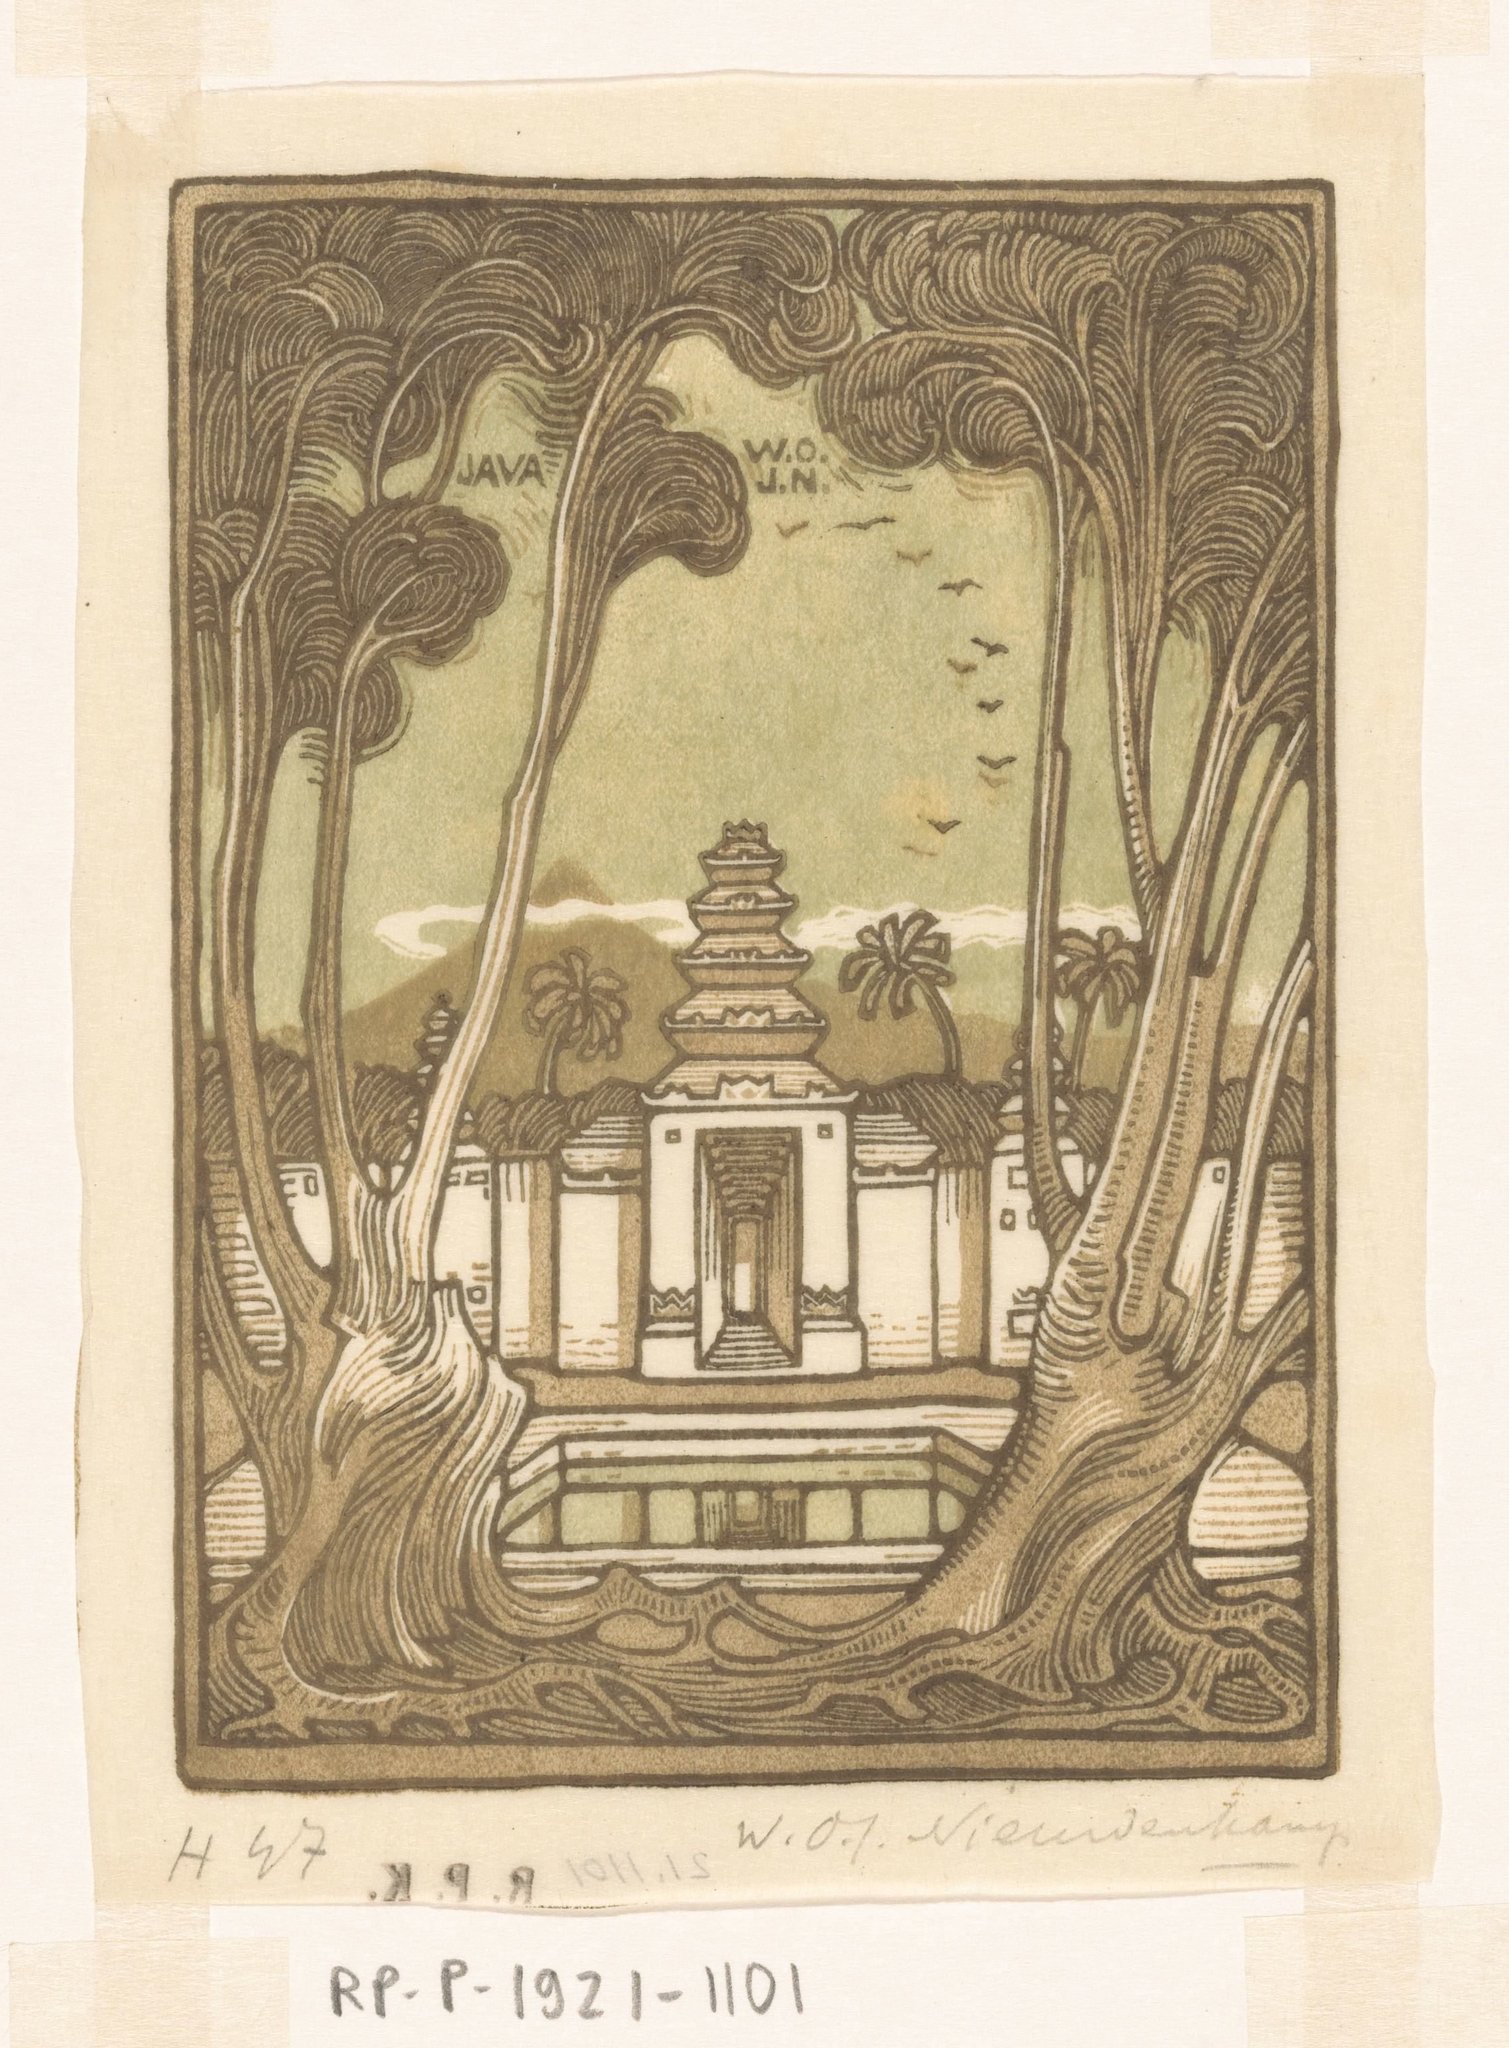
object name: print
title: Heile begraafplaats, Java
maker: wijnand otto jan nieuwenkamp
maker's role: draughtsman, print maker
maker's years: 1874-1950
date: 1903-1911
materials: paper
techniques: woodcut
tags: trees, gate, entrance, pond, pool, cemetery, park-like burying ground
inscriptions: collector's mark: Lugt 2233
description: Een plein met een vijver en een poort op een begraafplaats. Op de voorgrond twee waringinbomen, ook wel treurvijgen genoemd. Op de achtergrond een berg in een krans van wolken.